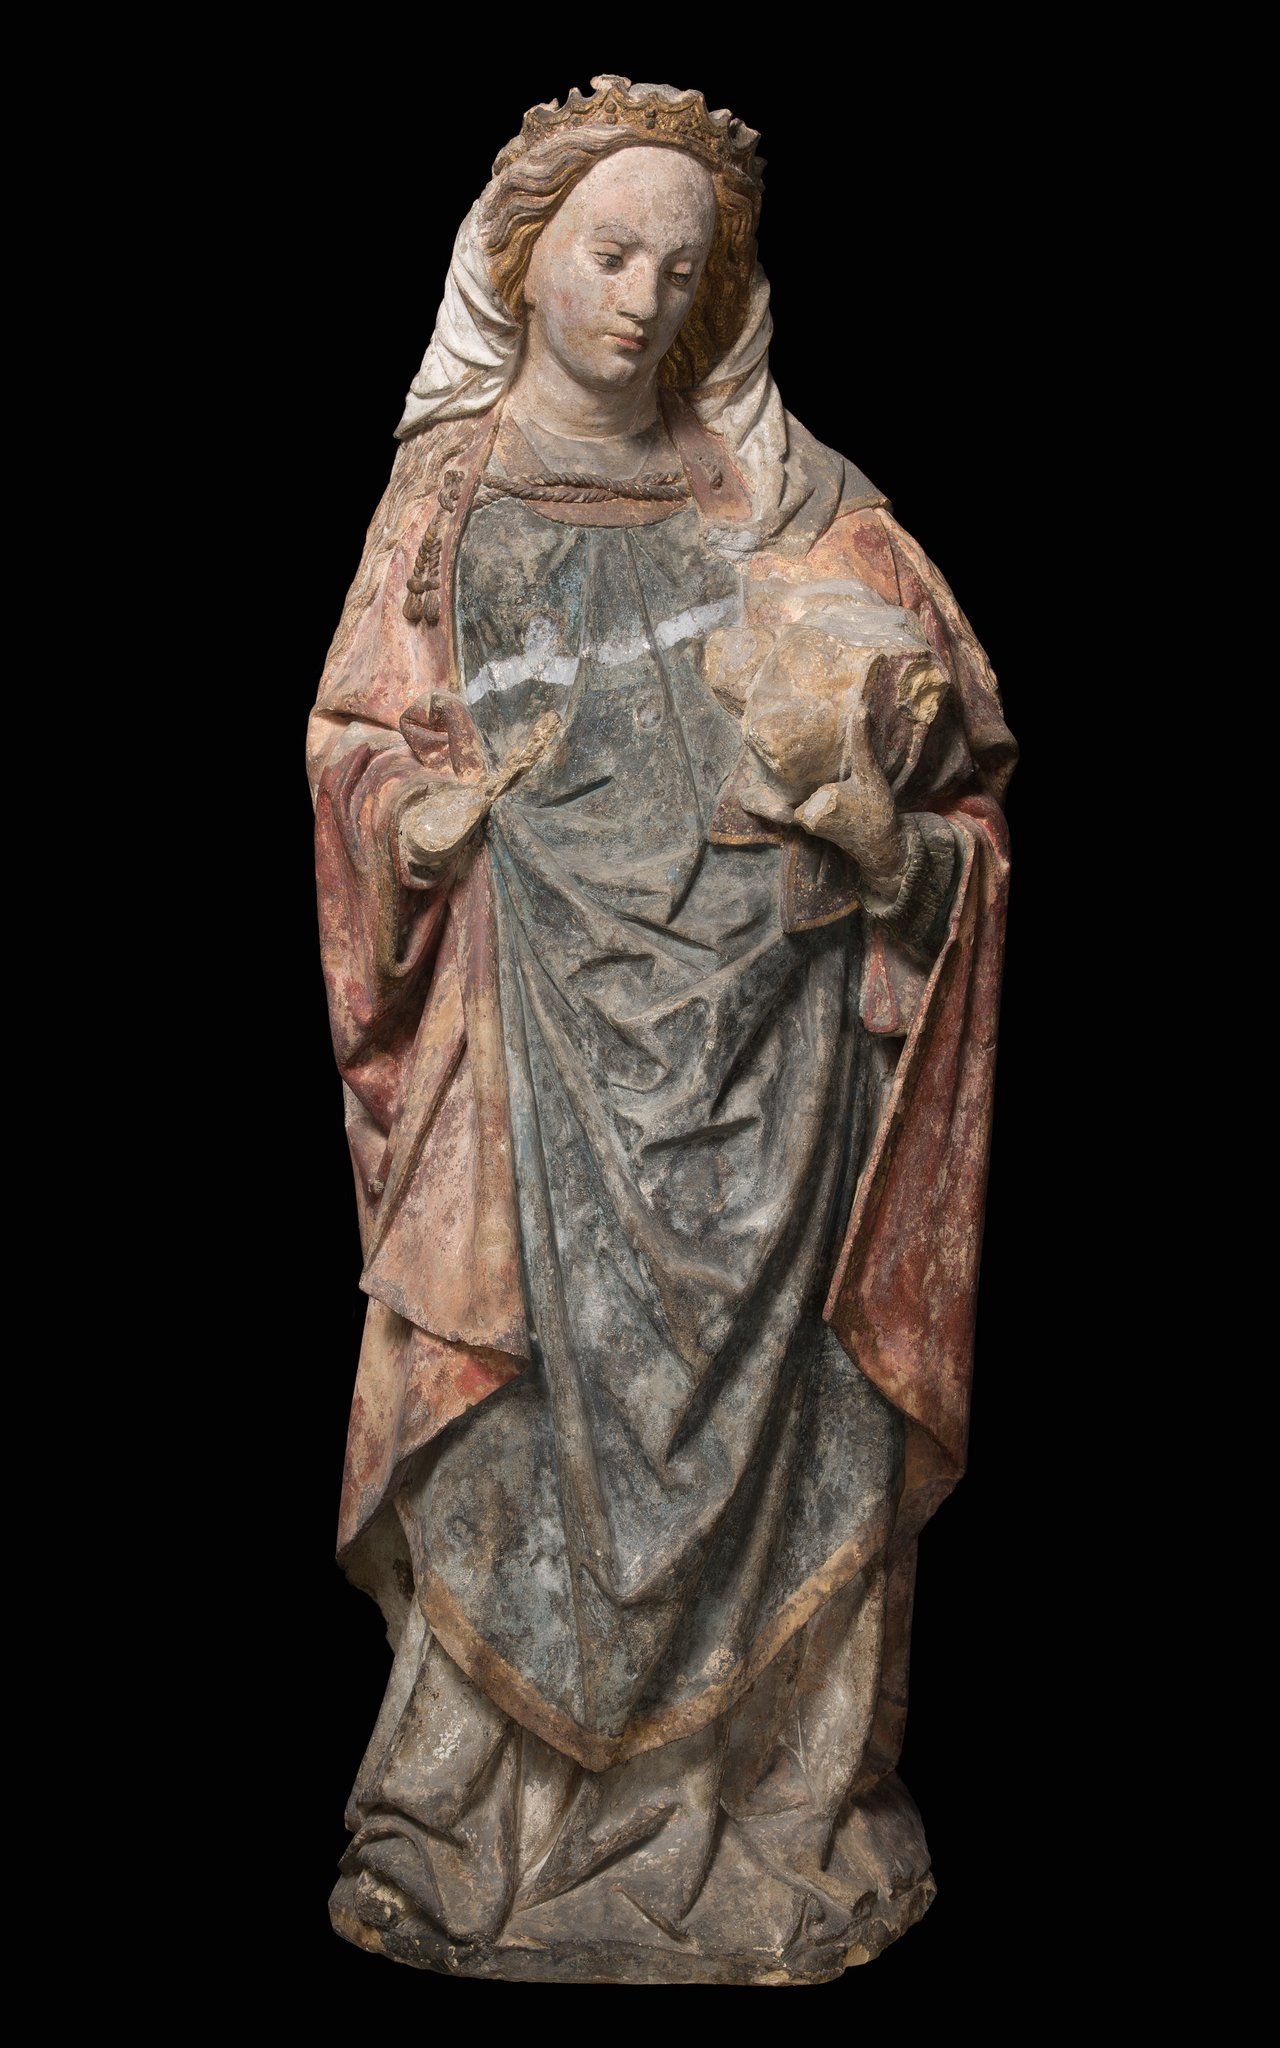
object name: statue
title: Virgin and Child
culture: french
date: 1401-1500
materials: stone